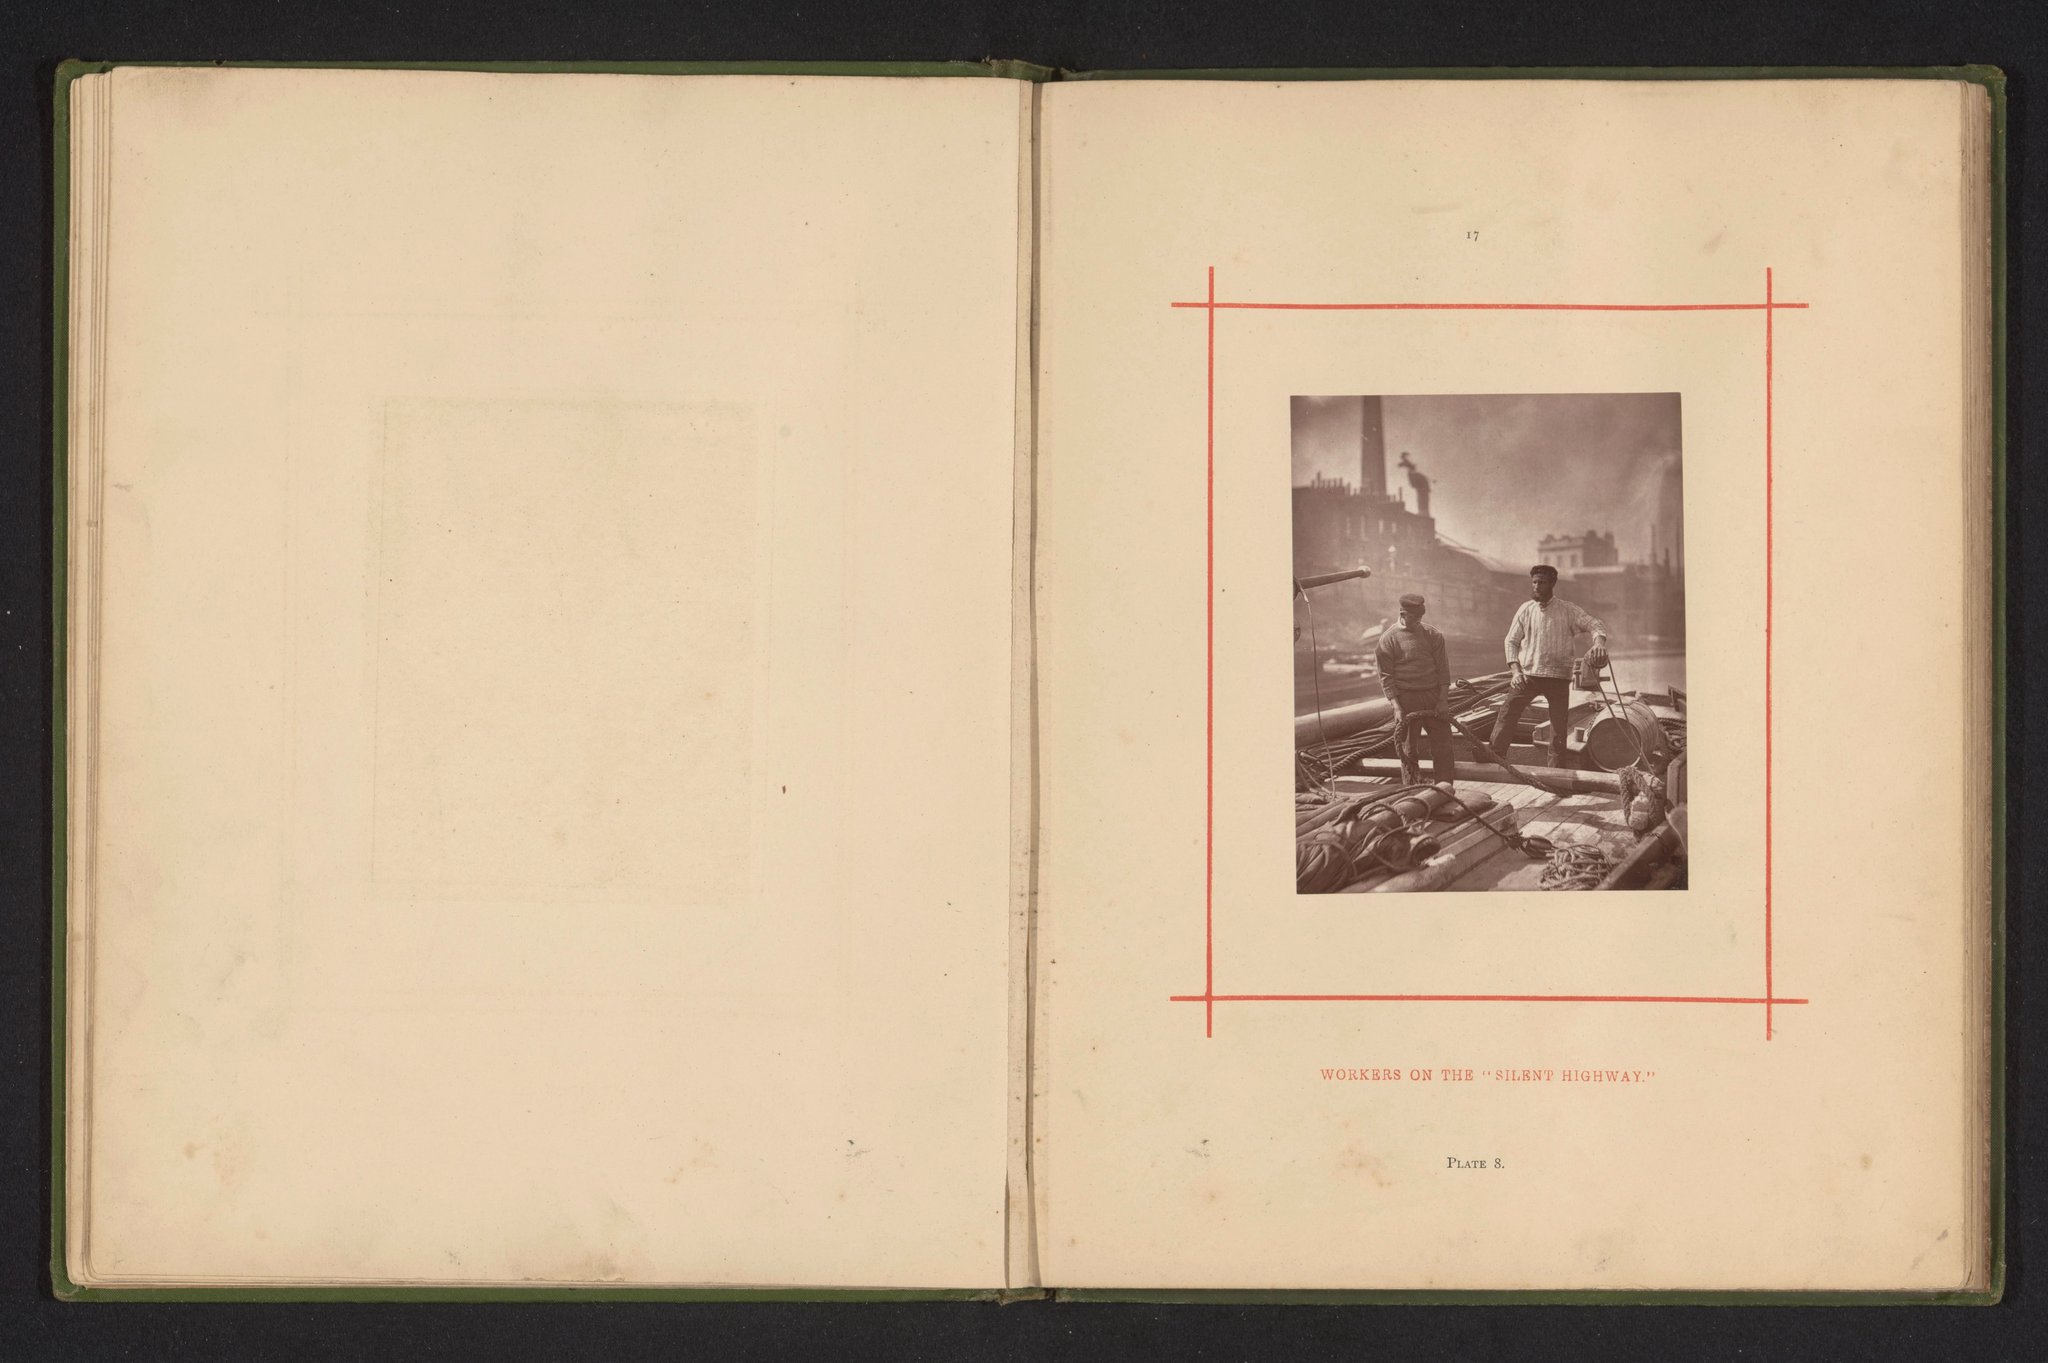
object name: photomechanical print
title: Workers on the "silent highway"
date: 1871-1881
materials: paper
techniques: woodburytype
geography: london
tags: diligence, omnibus, horse-tram, boat propelled by man or animal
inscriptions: number: ‘Plate 8.’